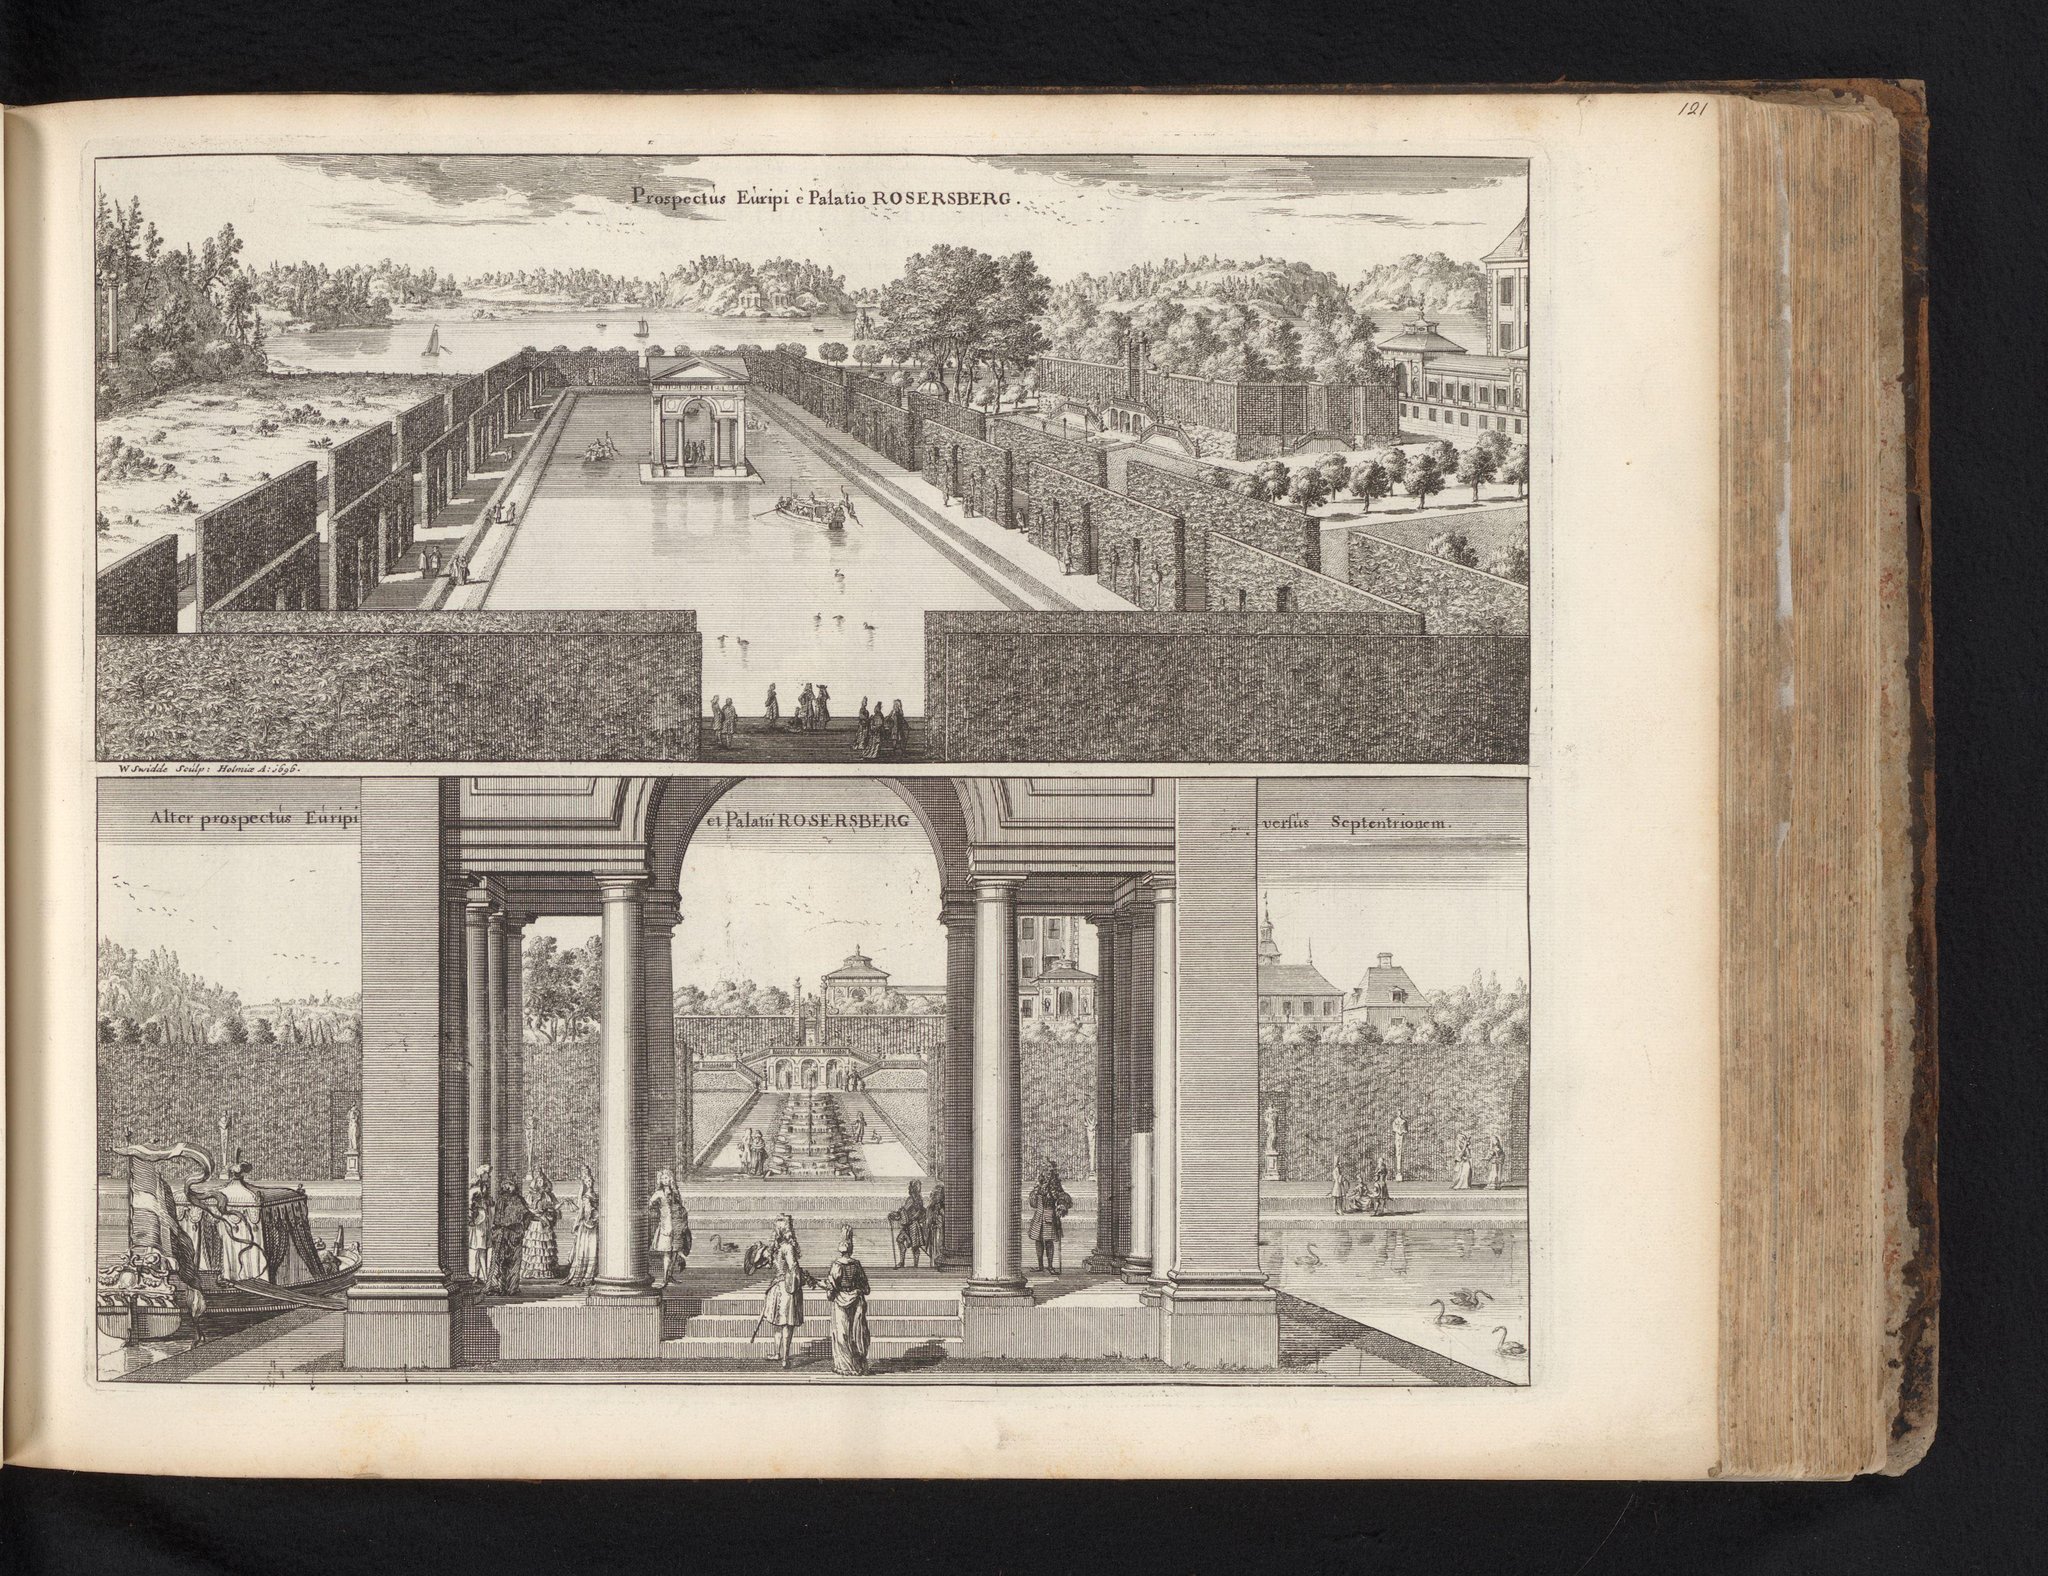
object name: album leaf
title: Gezicht op de gracht van slot Rosersberg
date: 1696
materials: paper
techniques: etching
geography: stockholm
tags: garden, housing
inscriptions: date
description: Kungliga Biblioteket, 'Suecia': http://www.kb.se/samlingarna/Kartor-bilder/Suecia-antiqua/ (geraadpleegd november 2016).